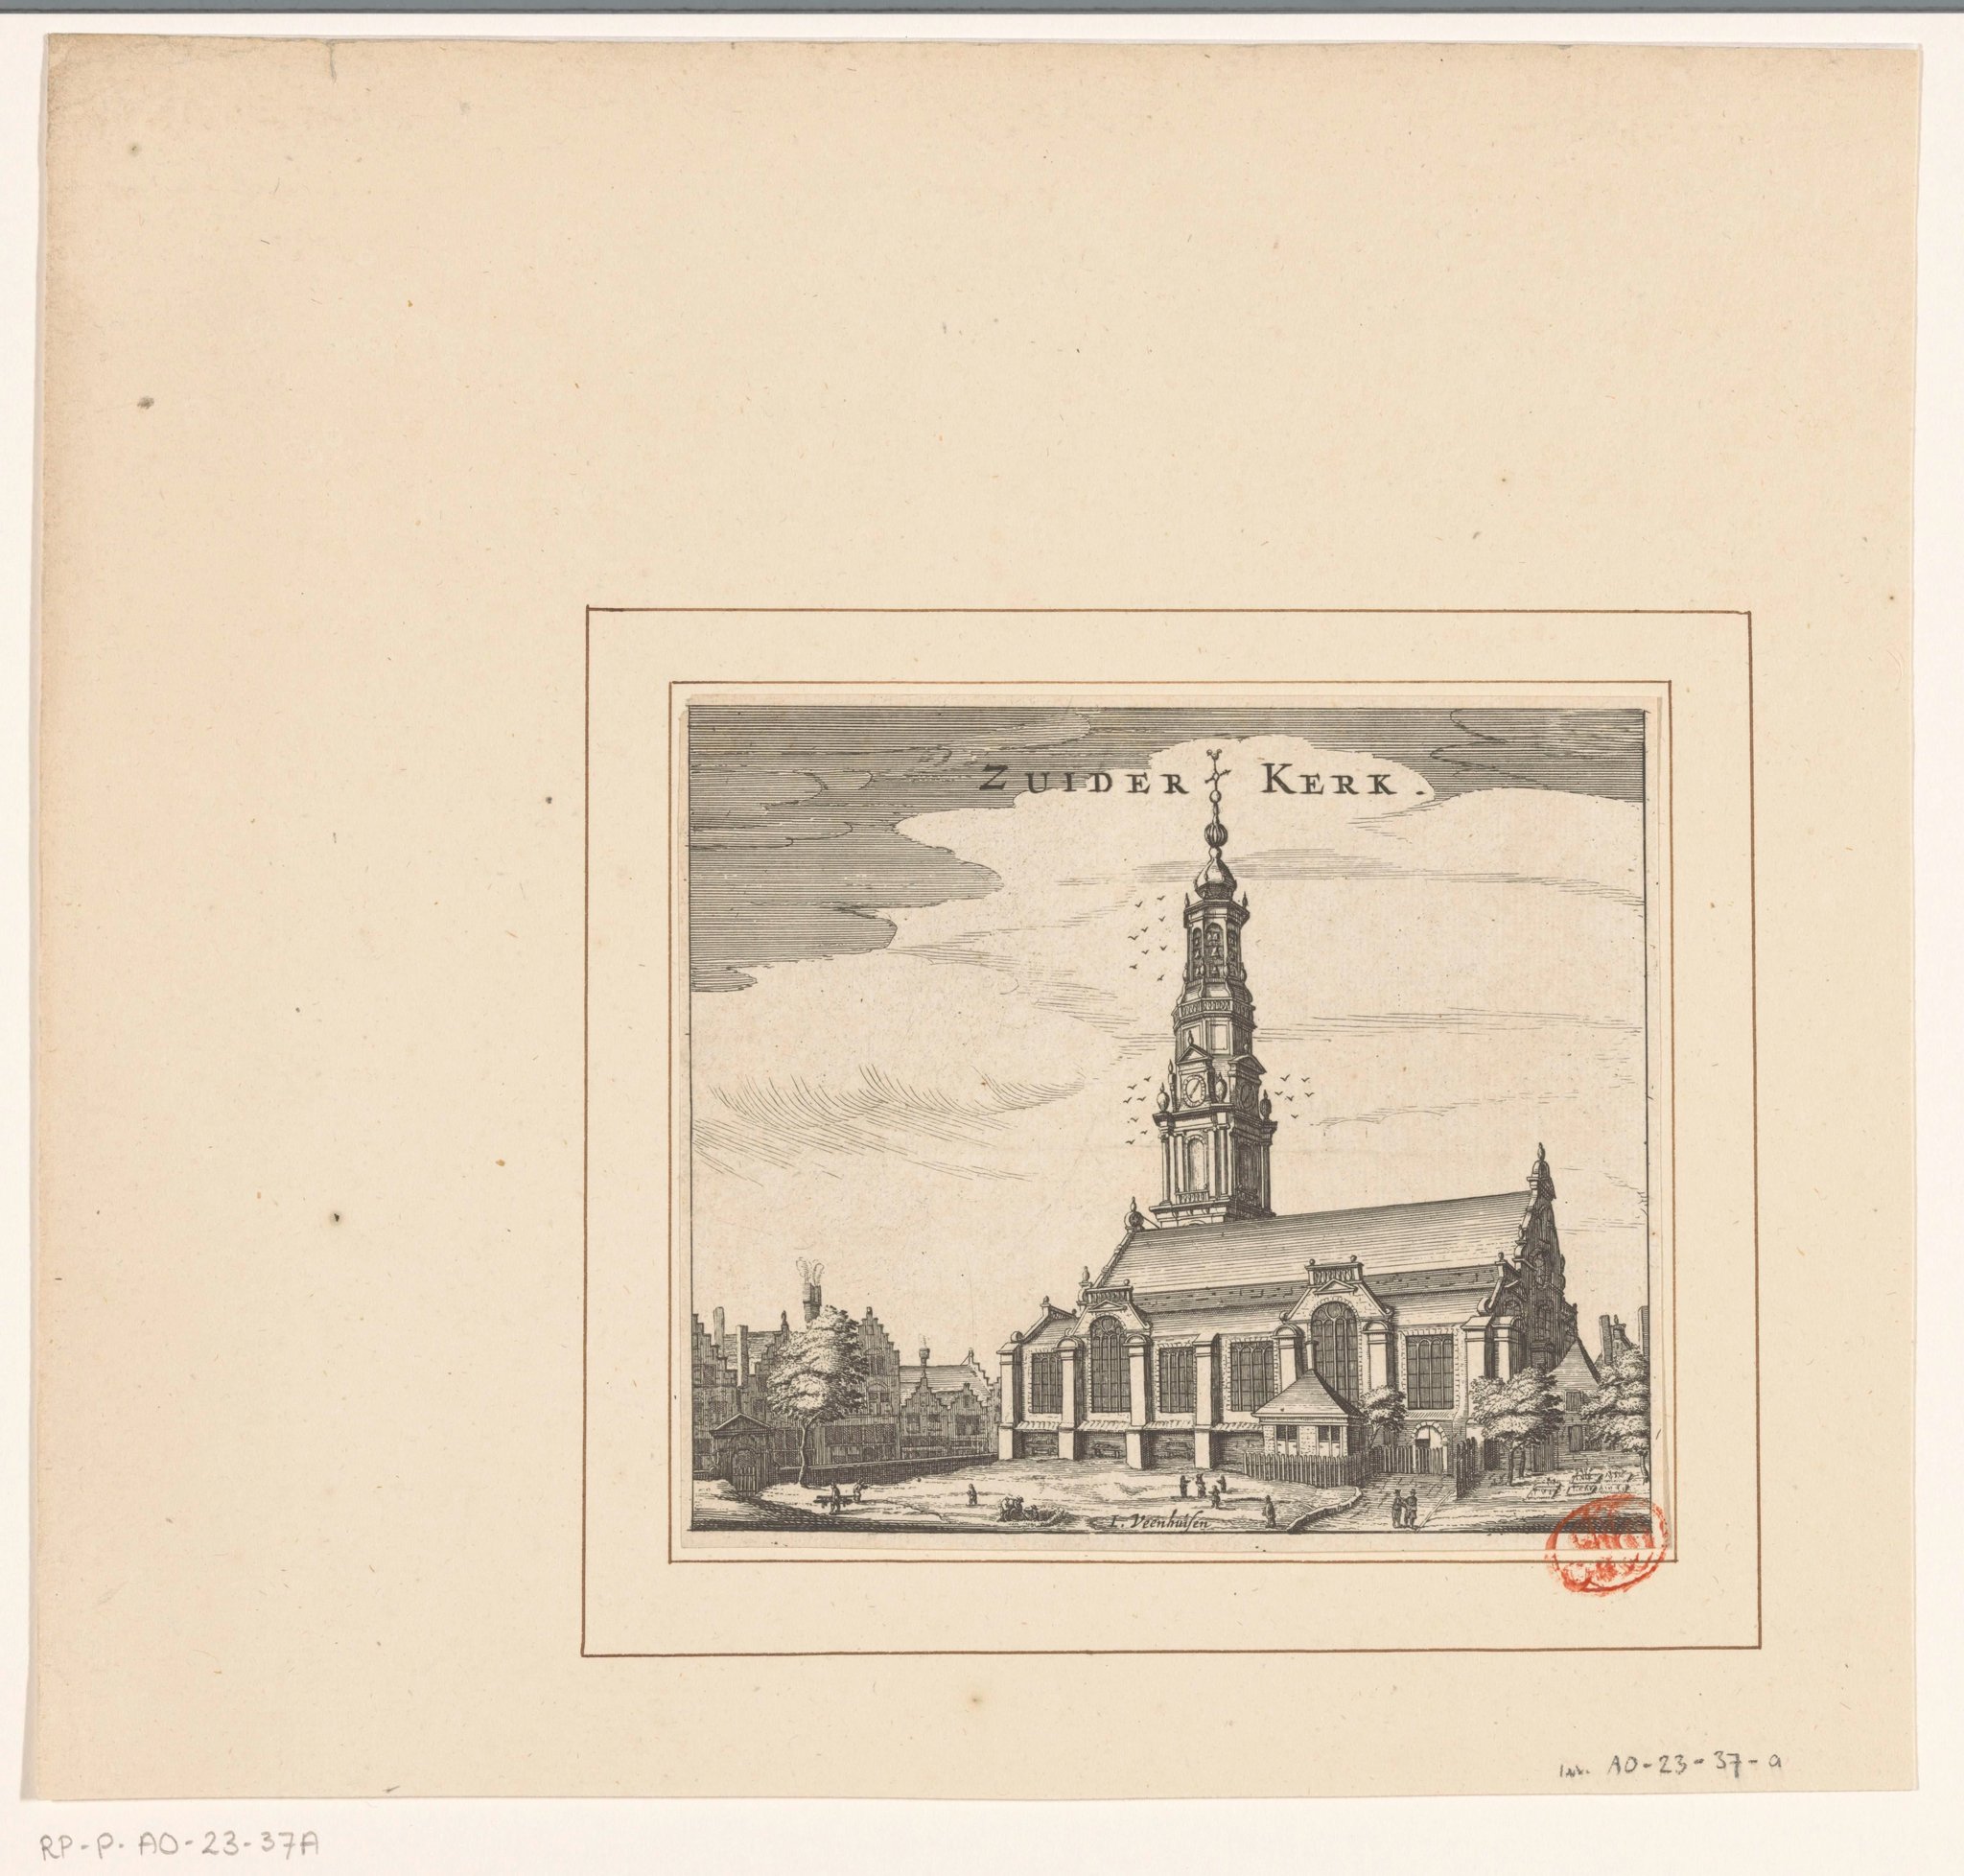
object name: book illustration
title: Zuider Kerk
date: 1664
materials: paper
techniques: engraving, etching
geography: amsterdam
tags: church (exterior)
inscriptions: collector's mark: Lugt 195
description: Huidige staat van prent ook gebruikt in: Fockens, Melchior. Beschrijving Der wijdt-vermaarde Koop-stadt Amstelredam, Van haar eerste beginselen, zedert den Jare 1203. oude Voorrechten, verscheyde Vergrootingenoude Voor-rechten, en verscheyde Vergrootingen (…). 3e druk. Amsterdam: Marcus Willemsz. Doornick, 1664. En in: Zesen, Philipp von. Beschrybung der Weidtberuhmde Kauf-Stadt Amstelredam / Beschreibung der Stadt Amsterdam darinnen von derselben ersten ursprunge bis auf gegenwartigen zustand (…). Amsterdam: Marcus Willemsz. Doornick, 1664. Eerste bekende staat van prent (rechtsboven genummerd: 225) ook gebruikt in: Fockens, Melchior. Beschrijvinge Der wijdt-vermaarde Koop-stadt Amstelredam, Van hare eerste beginselen, oude Voor-rechten, en verscheyde Vergrootingen (…). 1e druk. Amsterdam: Marcus Willemsz. Doornick, 1662. En in: Fockens, Melchior. Beschrijvinge Der wijdt-vermaarde Koop-stadt Amstelredam, Van hare eerste beginselen, oude Voor-rechten, en verscheyde Vergrootingen (…). 2e druk. Amsterdam: Marcus Willemsz. Doornick, 1662. Derde bekende staat (met toevoeging Franse titel) ook gebruikt in: Domselaer, Tobias en Isaac Commelin. Beschryvinge van Amsterdam : haar eerste oorspronk uyt den huyze der heeren van Aemstel en Aemstellant (…). 6 delen. Amsterdam: Marcus Willemsz van Doornick, 1665. Vierde bekende staat (rechtsboven genummerd: 12) ook gebruikt in verschillende latere zeventiende- en achttiende-eeuwse publicaties.